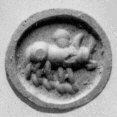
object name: stamp seal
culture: sasanian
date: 201-700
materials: stone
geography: iran or mesopotamia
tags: animals